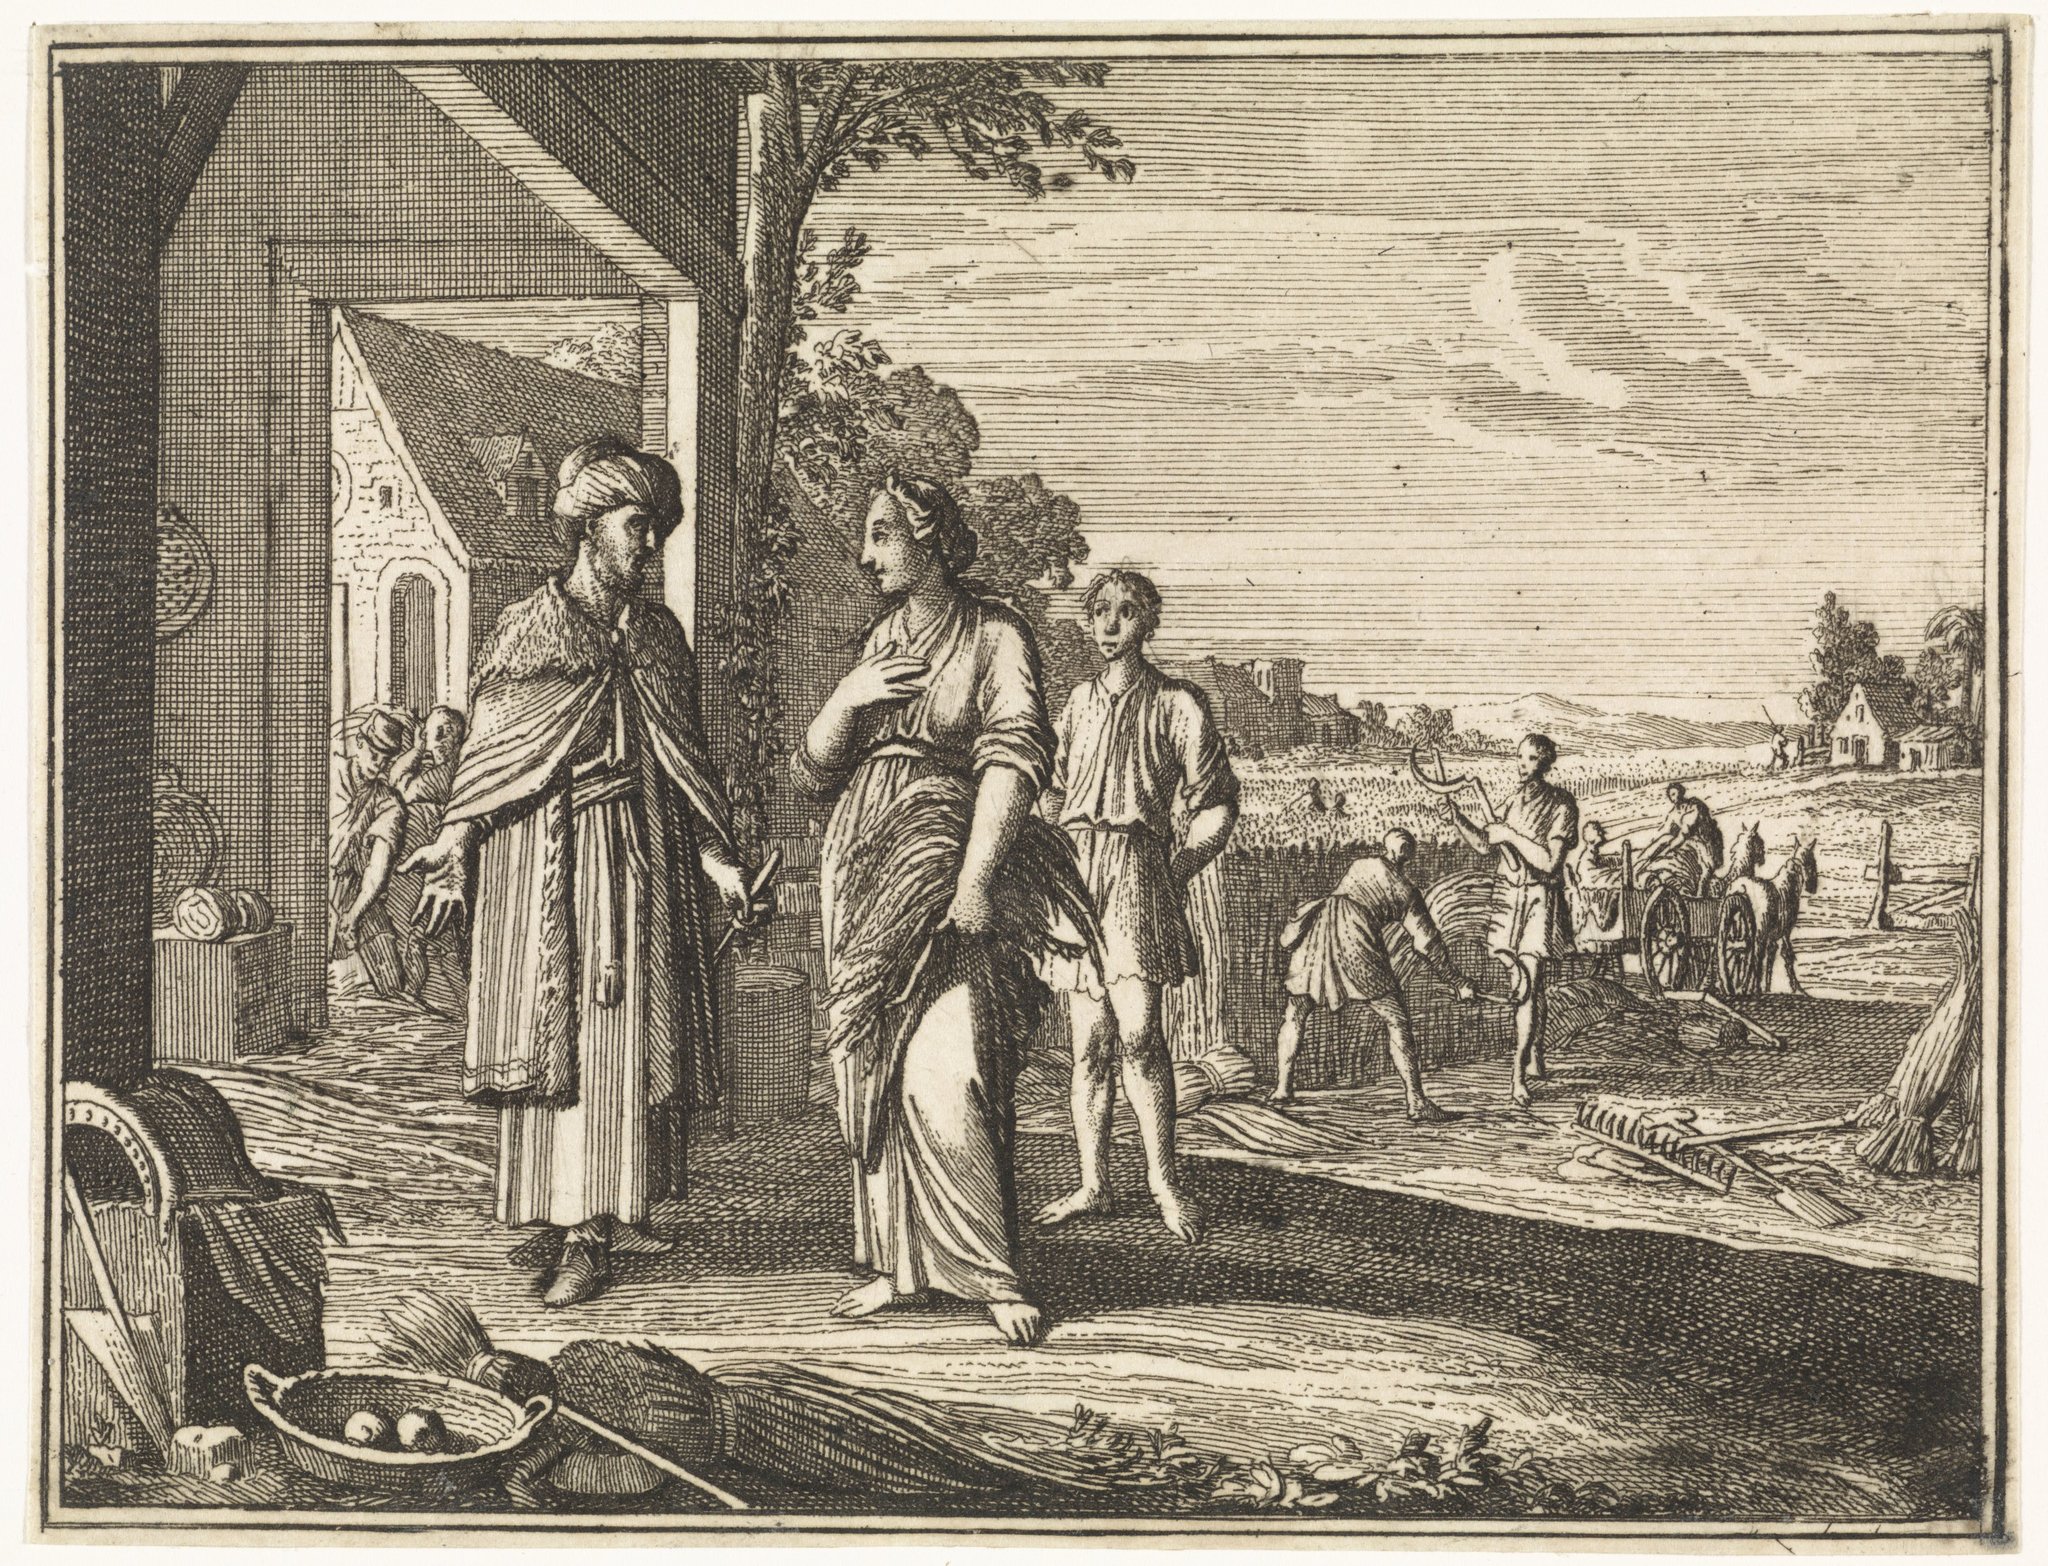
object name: print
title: Boaz spreekt tot Ruth op de akker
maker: caspar luyken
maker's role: draughtsman, print maker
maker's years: 1672-1708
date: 1712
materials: paper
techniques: etching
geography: amsterdam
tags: boaz speaks to ruth; ruth usually bowing down, or kneeling before him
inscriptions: collector's mark: Lugt 2228, number: ‘93’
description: Illustratie uit: Luyken, Jan. De schriftuurlyke geschiedenissen en gelykenissen van het Oude en Nieuwe Verbond, 2 delen. Amsterdam: Wed. Pieter Arentsz II en Cornelis van der Sys, 1712, dl. I.